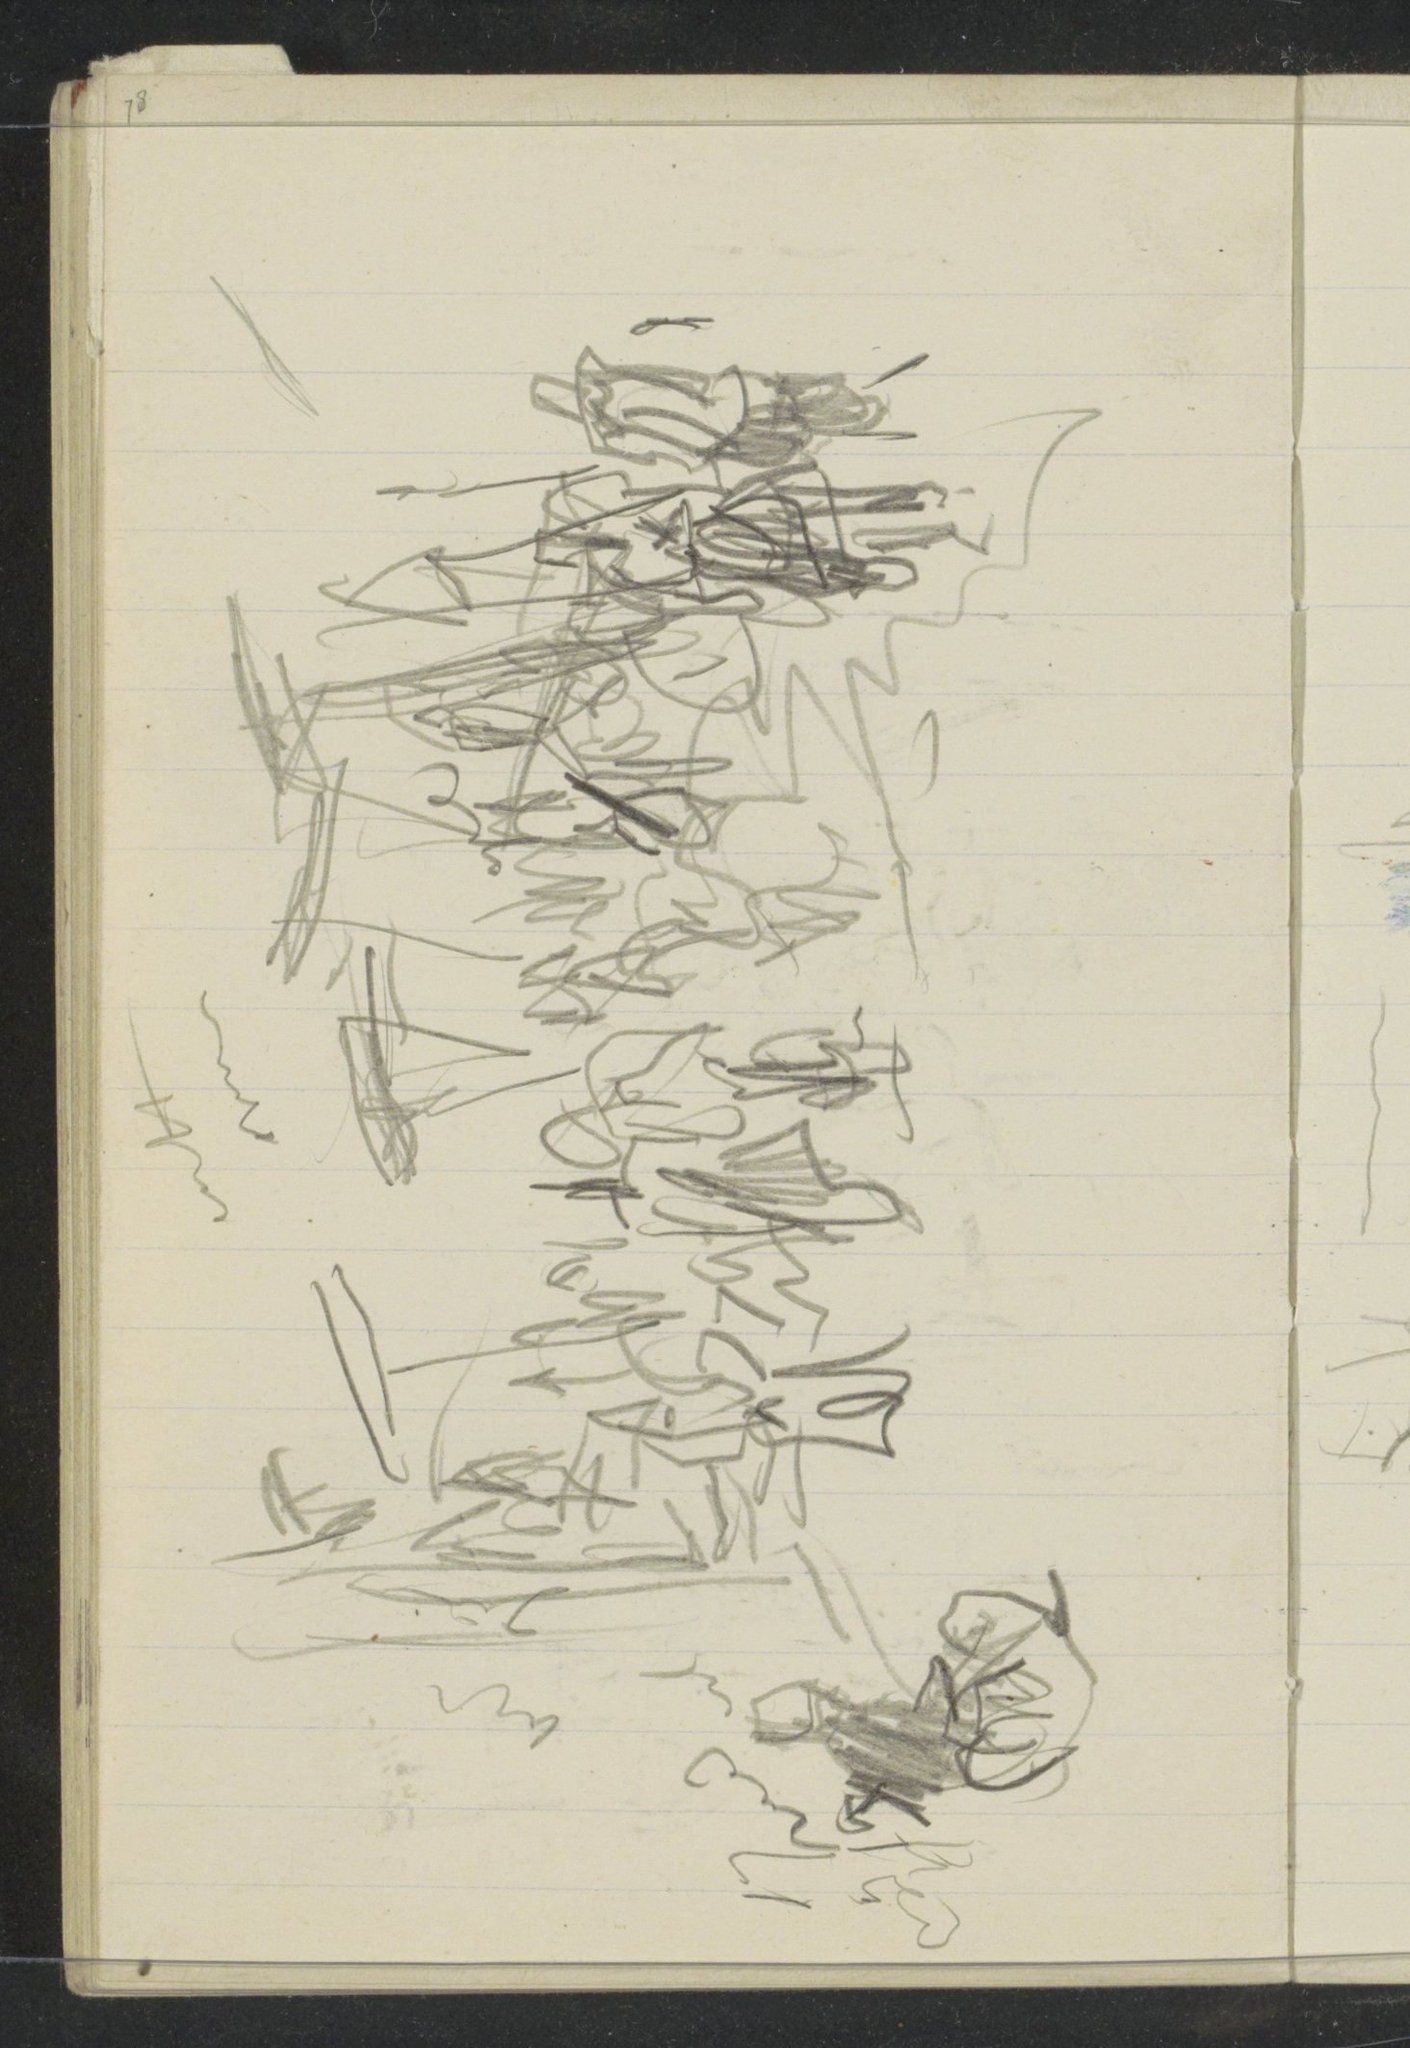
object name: sketchbook leaf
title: Optocht van figuren met parasols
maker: marius bauer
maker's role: draughtsman, print maker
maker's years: 1867-1932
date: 1931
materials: pencil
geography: indonesia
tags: walking, parasol, sunshade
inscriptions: kleurnotitie, handgeschreven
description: Pagina 78 uit een schetsboek met 74 bladen.